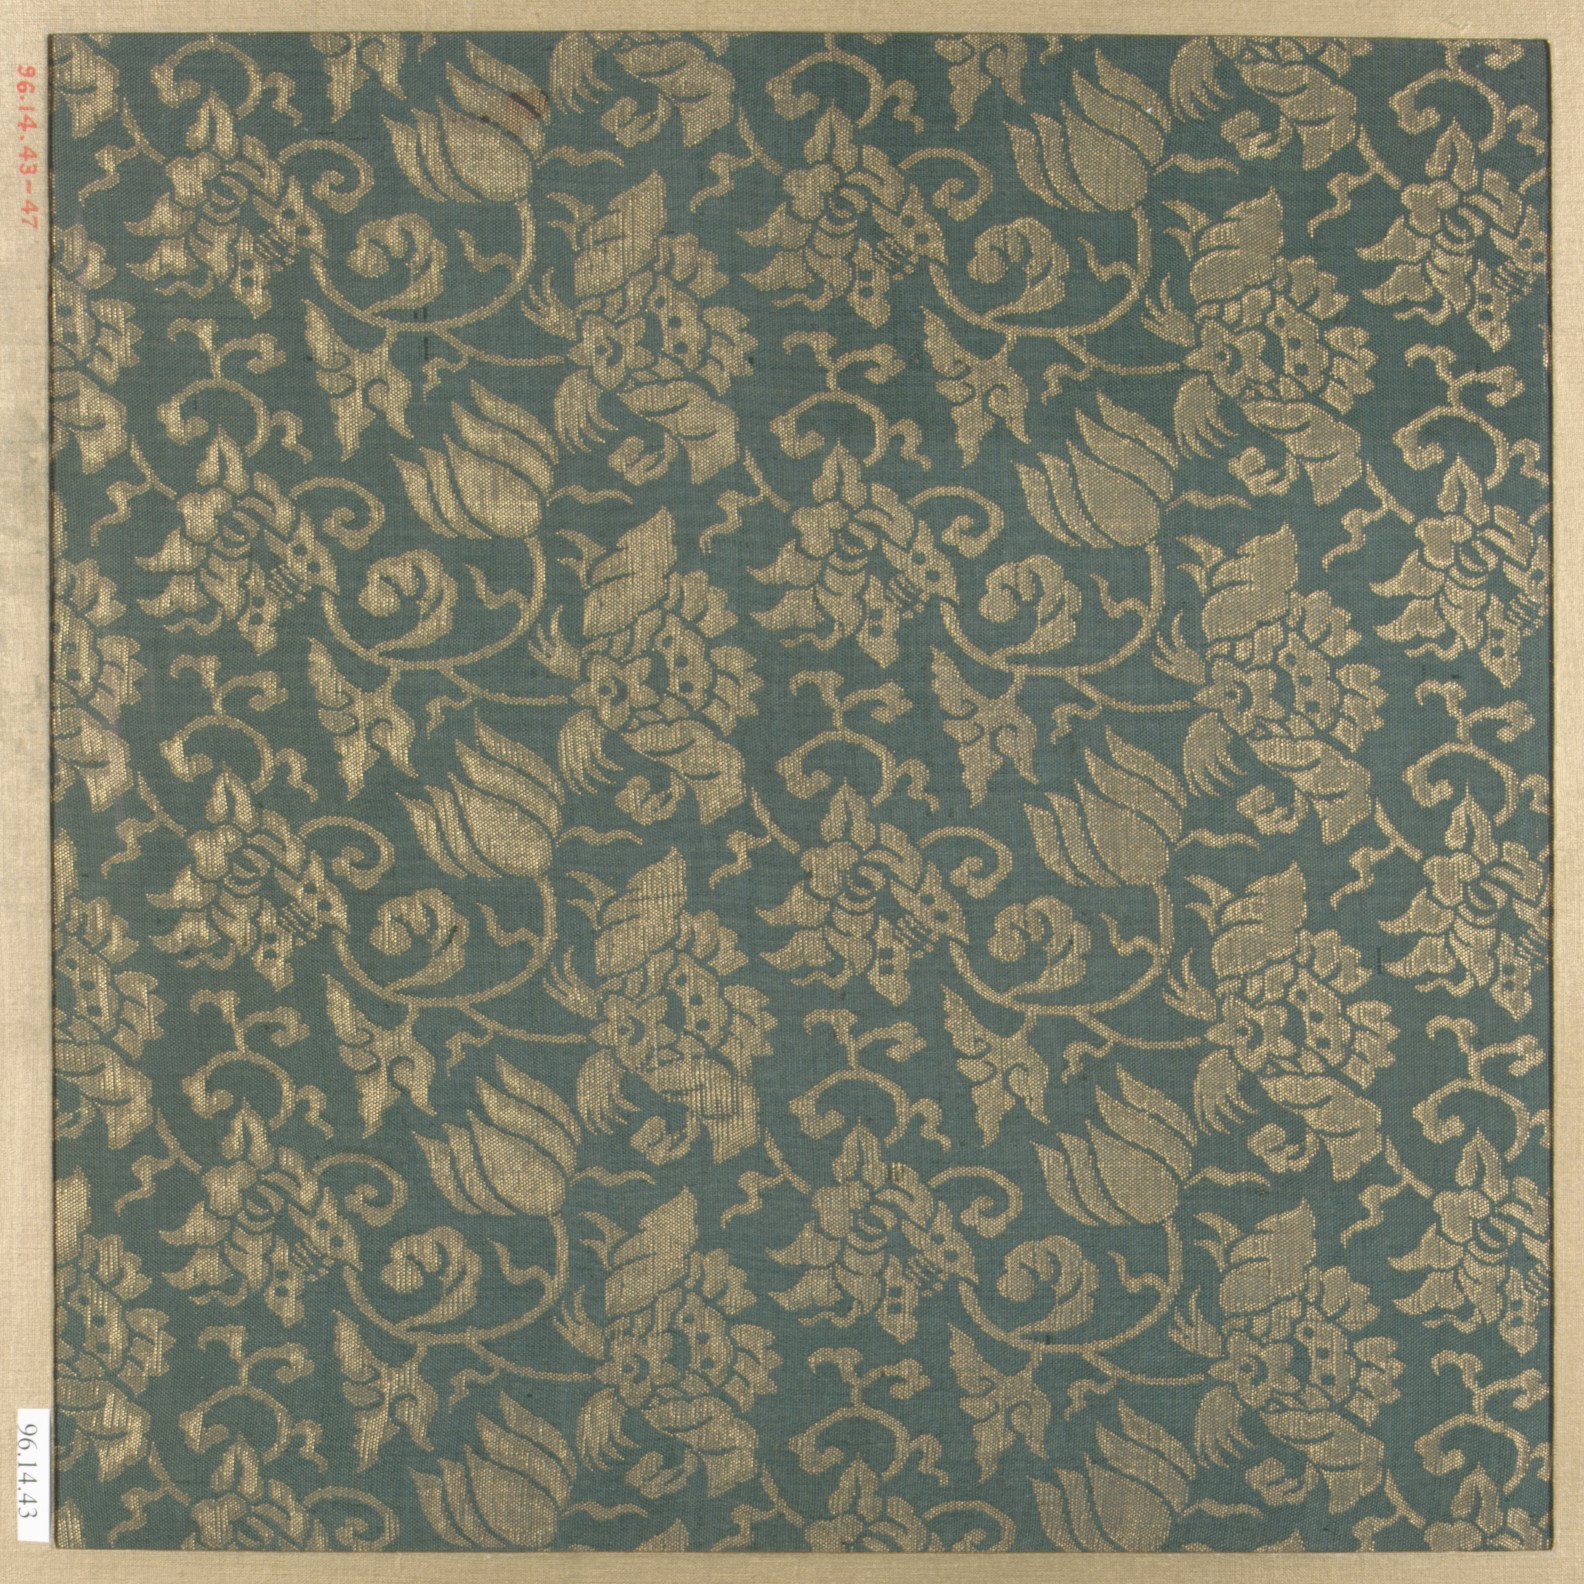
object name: piece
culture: japanese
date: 1701-1800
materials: silk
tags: flowers